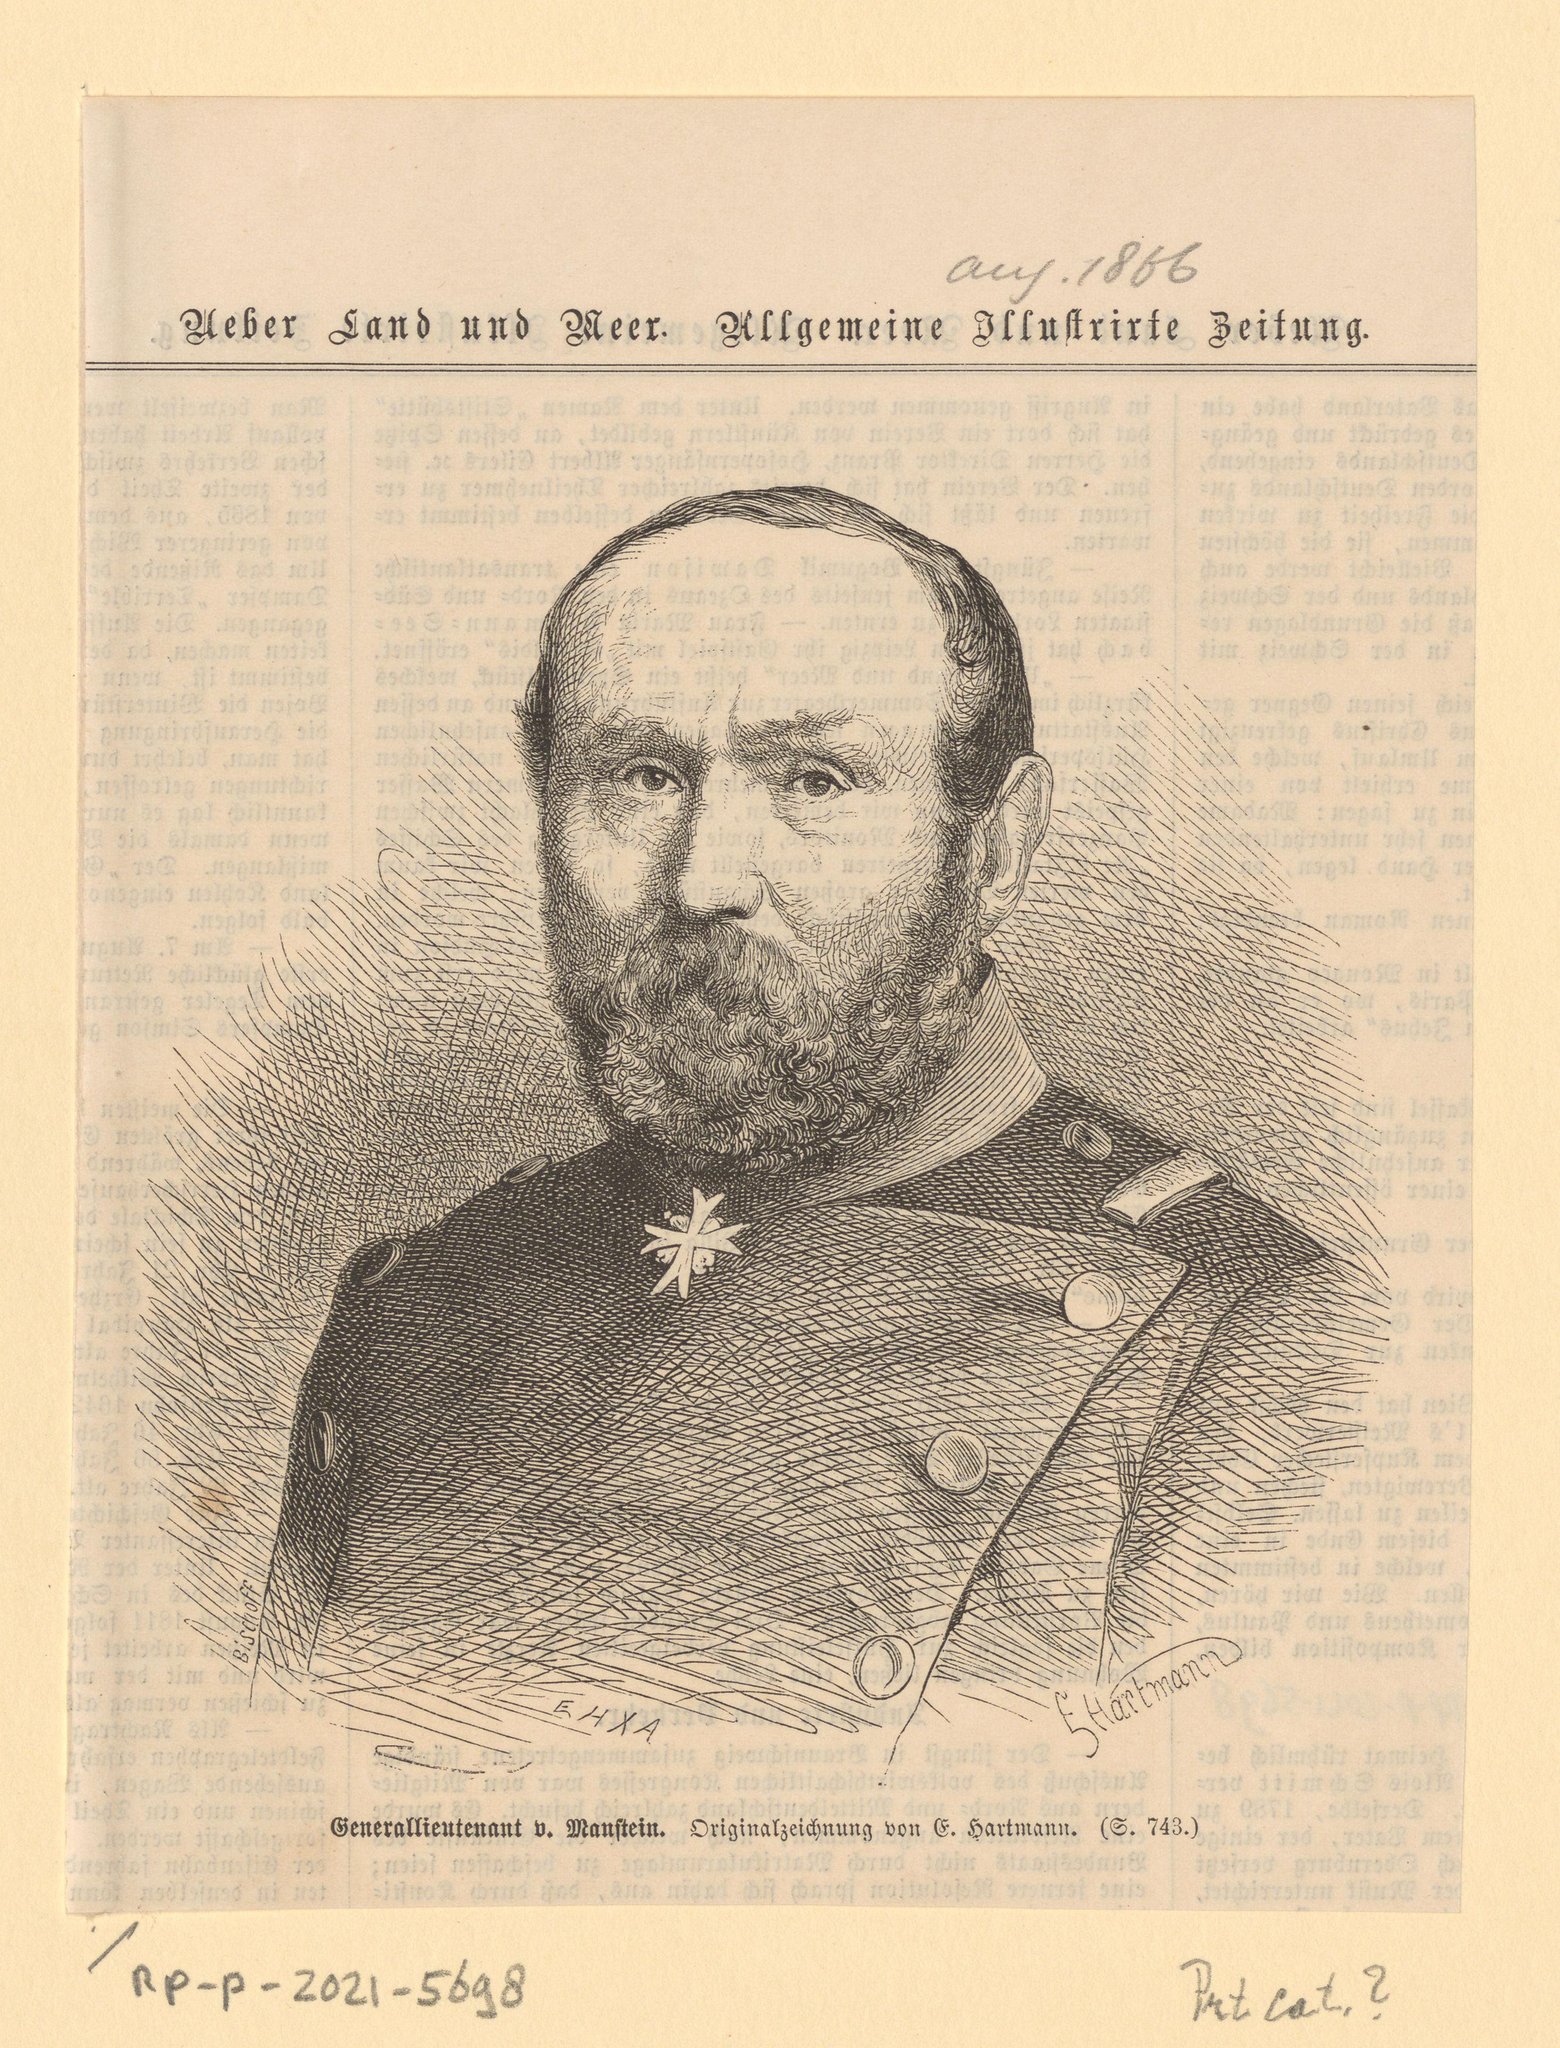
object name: print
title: Portret van Albrecht Gustav von Manstein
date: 1808-1866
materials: paper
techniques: letterpress printing, engraving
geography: stuttgart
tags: commander-in-chief, general, marshal, historical persons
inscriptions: inscription: ‘aug. 1866’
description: Prent uit: Über Land und Meer. Allgemeine illustrirte Zeitung 8 (1866), nr. 47, augustus 1866.